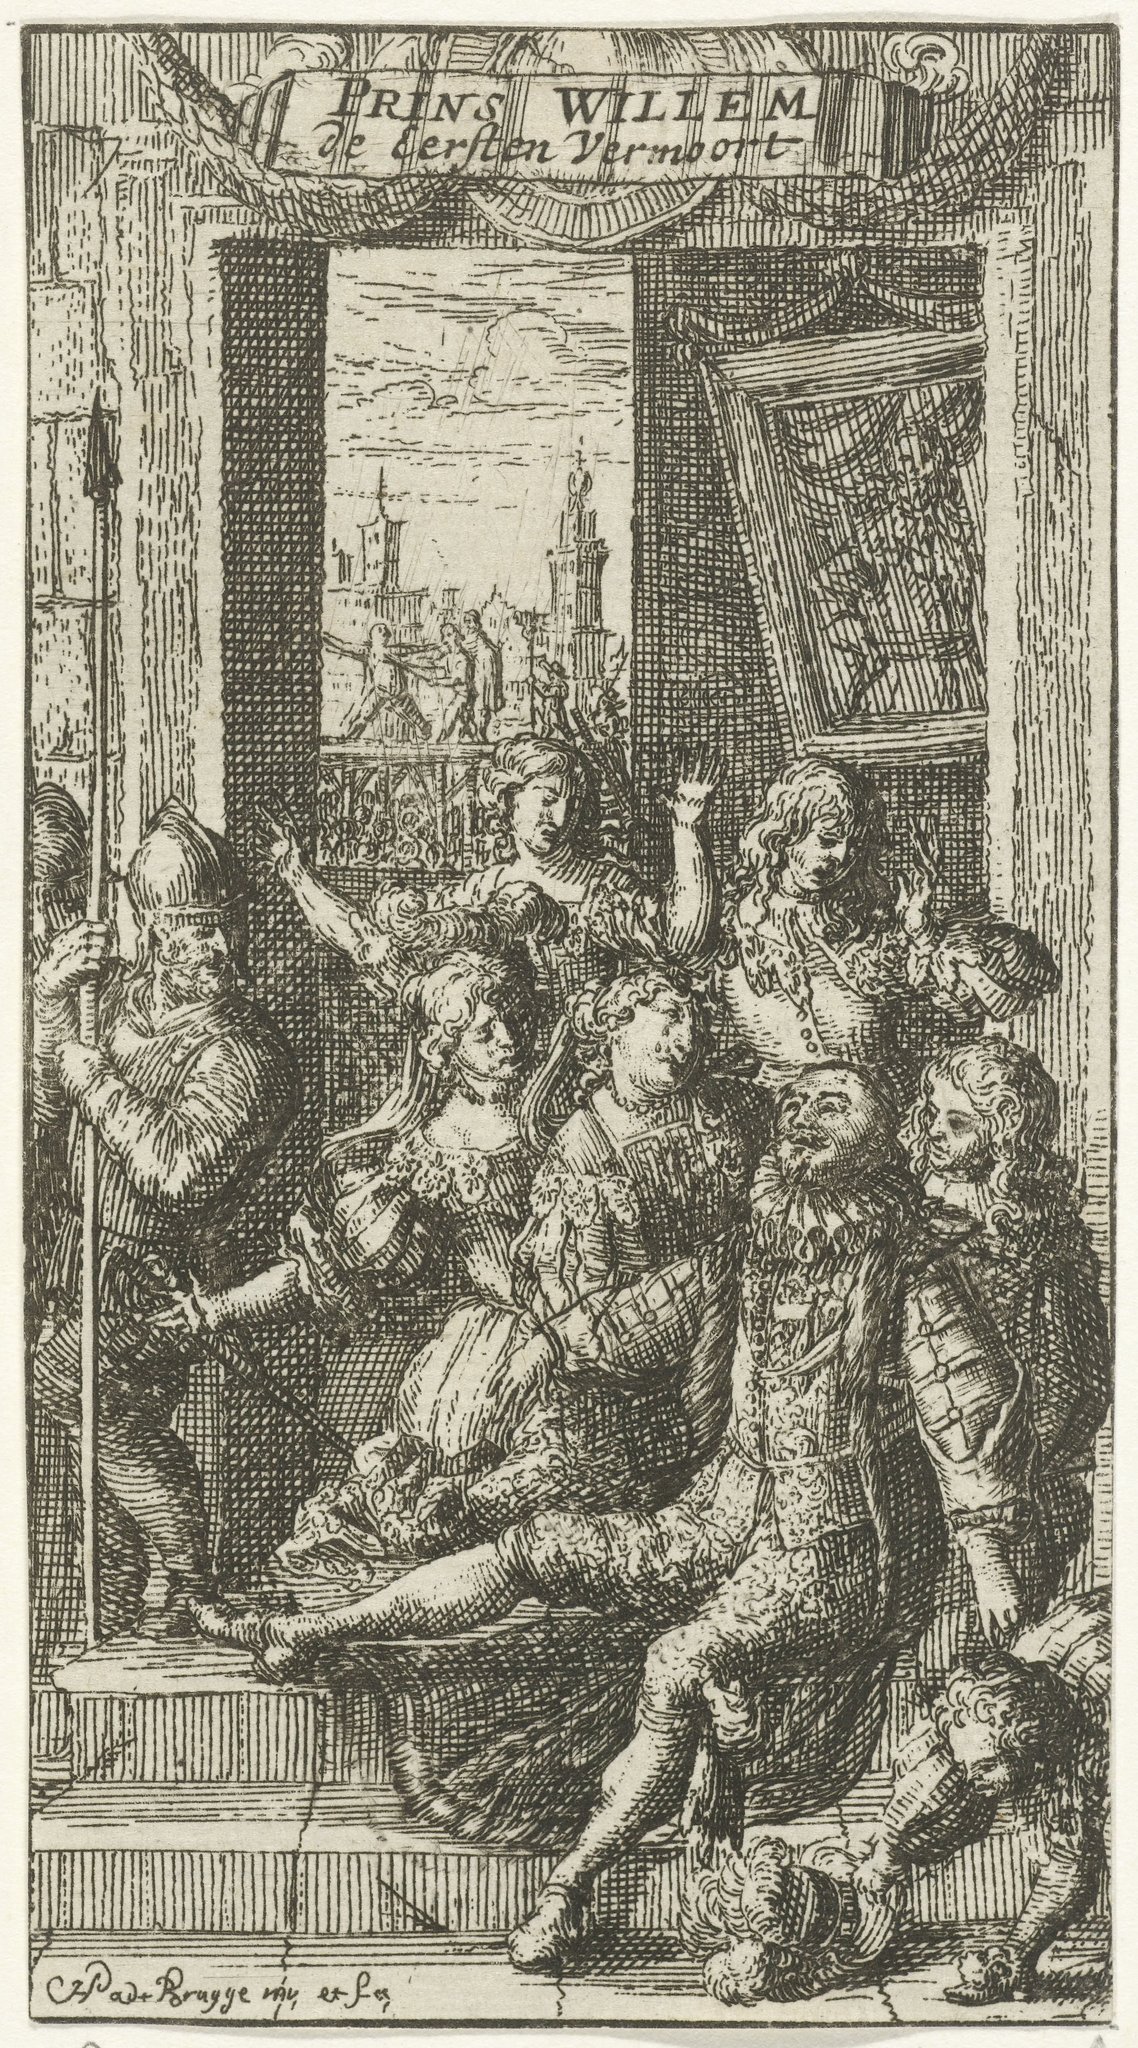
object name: book illustration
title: Moord op de prins van Oranje, 1584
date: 1677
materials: paper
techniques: etching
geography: amsterdam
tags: delft, william i (prince of orange), on the scaffold or place of execution, attempt, political murder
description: De prent is gebruikt voor Velde, Abraham van de. De wonderen des Alder-hoogsten, ofte aenwijsinge van de oorsaecken, wegen en middelen, waerdoor de Geunieerde Provintien uyt hare vorige onderdruckinge soo wonderbaerlijck, tegen vermoeden van de heele wereldt, tot soo grooten macht, rijckdom, eere en ontsaggelijckheydt zijn verheven, Amsterdam: Jan Claesz. ten Hoorn, 1677.